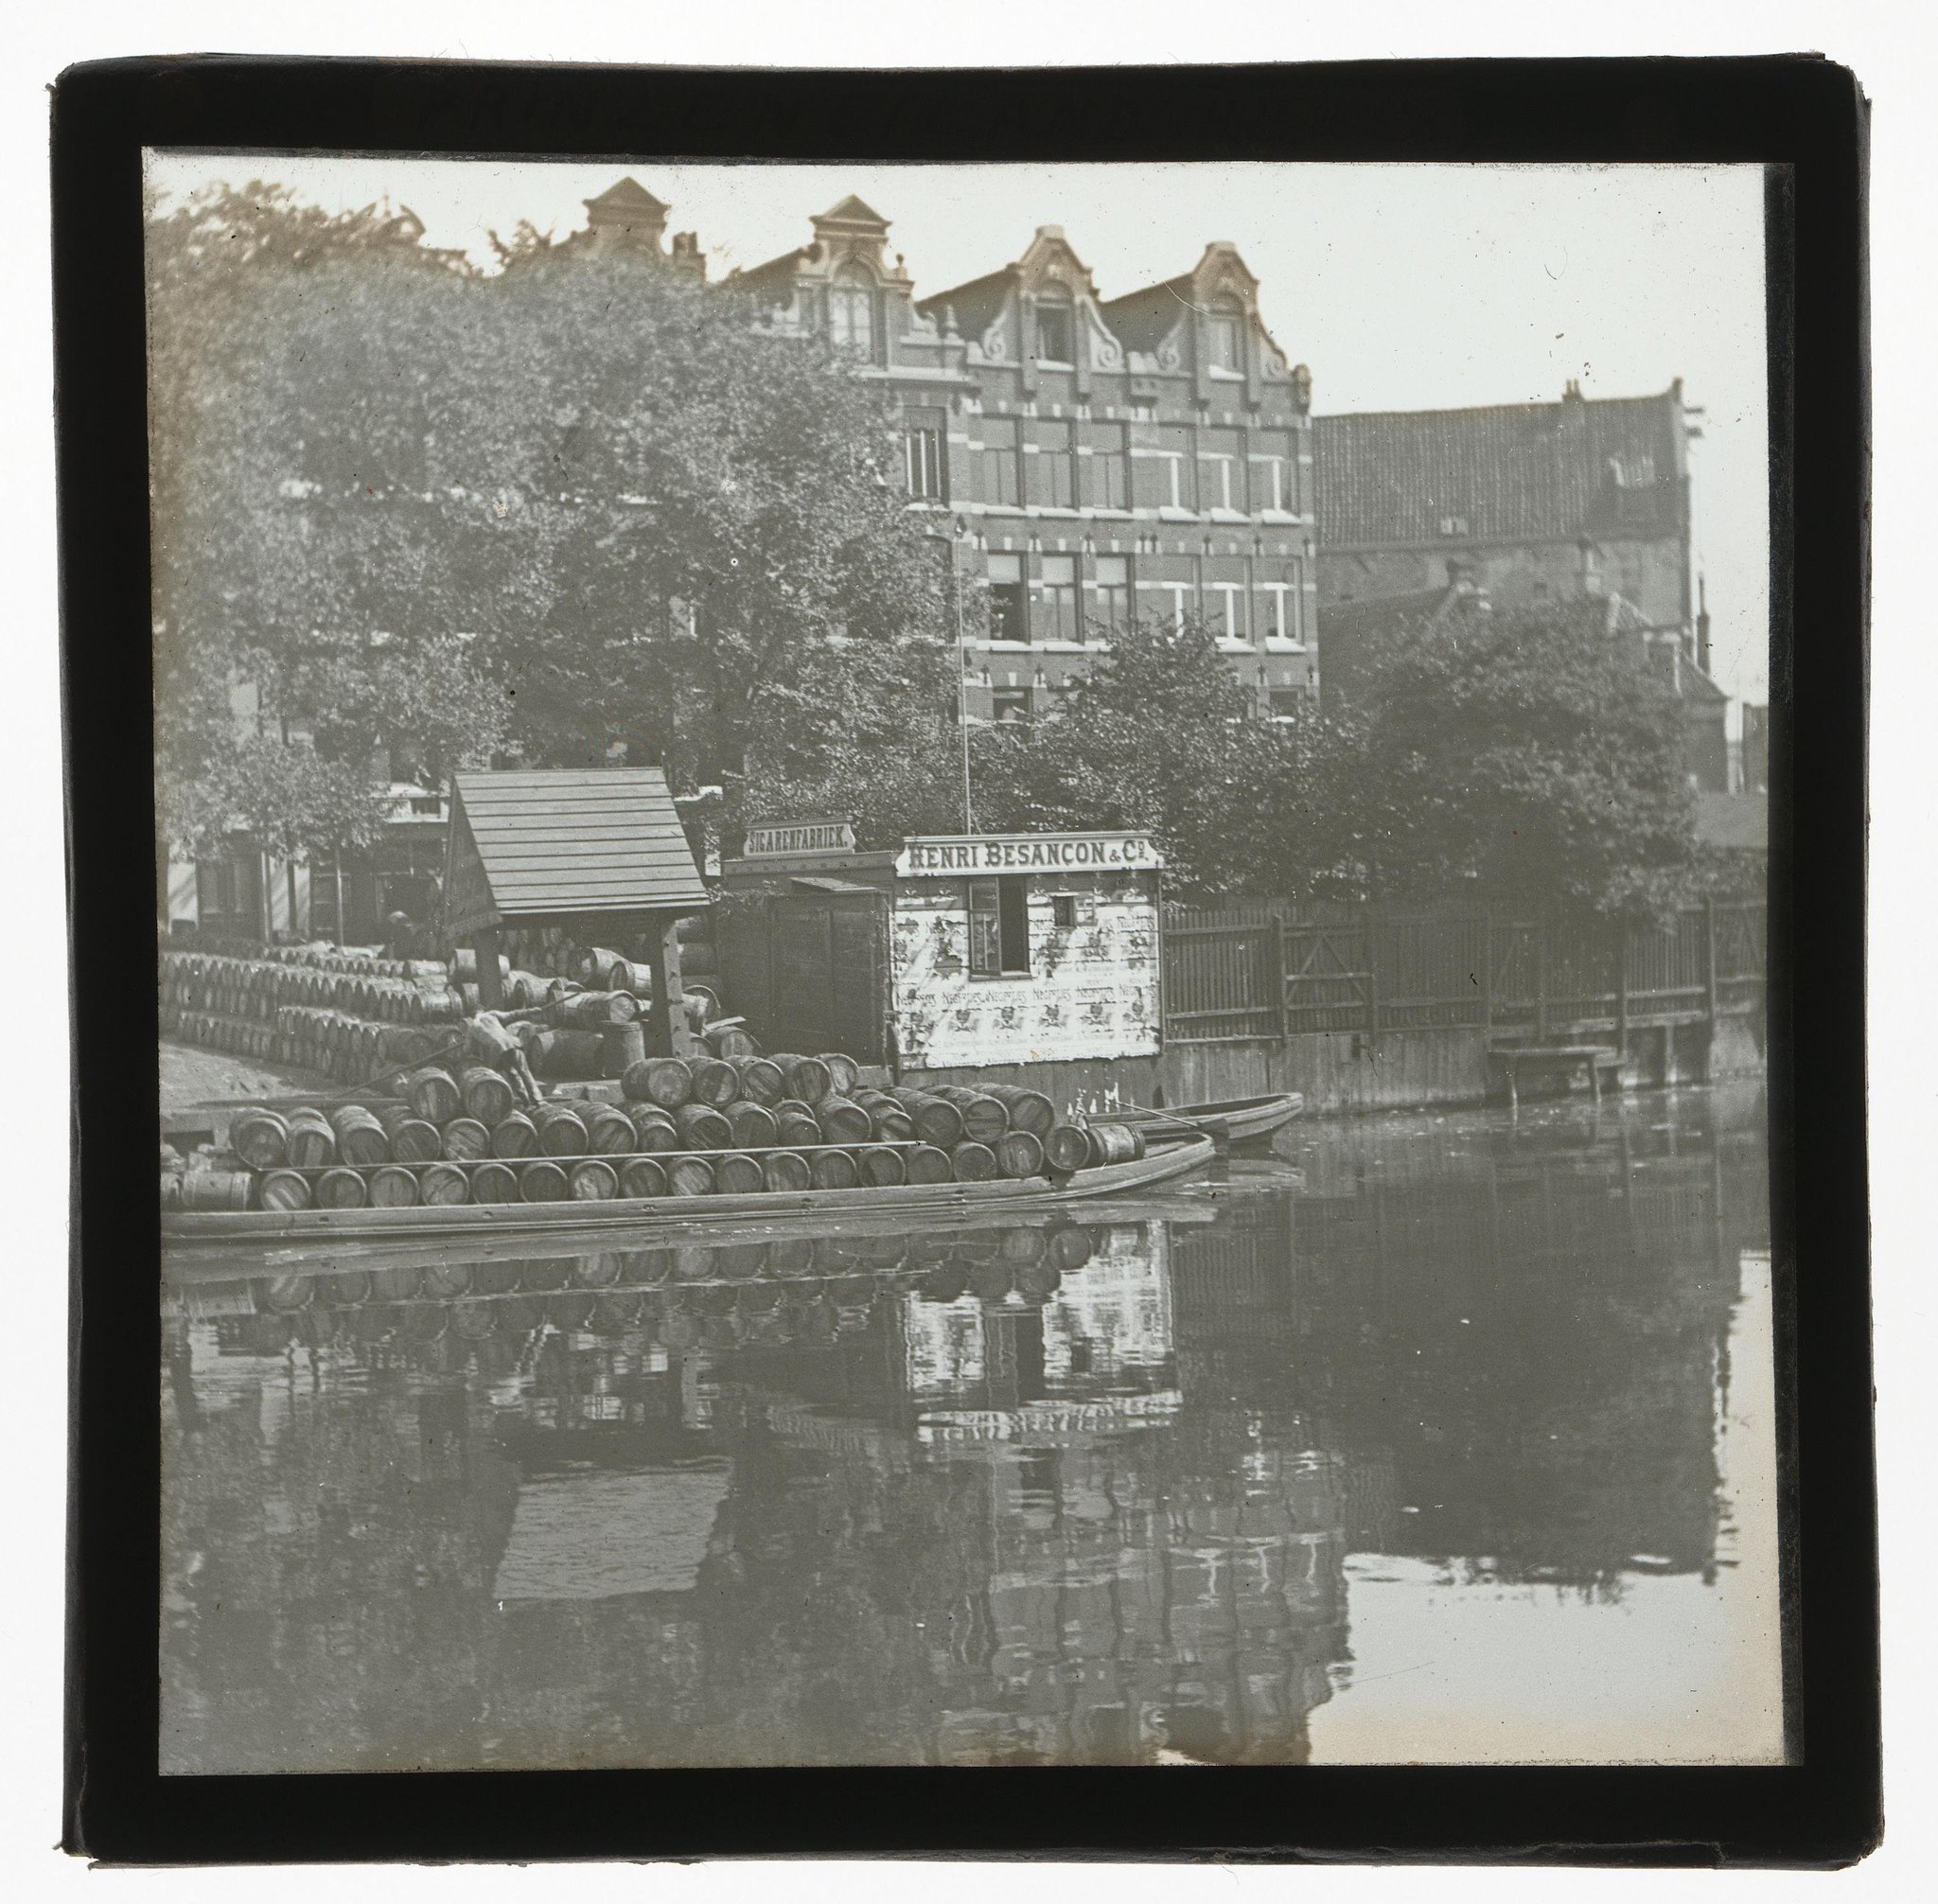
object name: lantern slide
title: Prinseneiland met vrachtschepen en sigarenfabriek Henri Besancon & Co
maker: machiel gerrit george suyver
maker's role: fotograaf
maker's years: 1872-1933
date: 1890-1898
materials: glass, paper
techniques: gelatin silver transparency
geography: amsterdam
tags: canal, ships (in general)